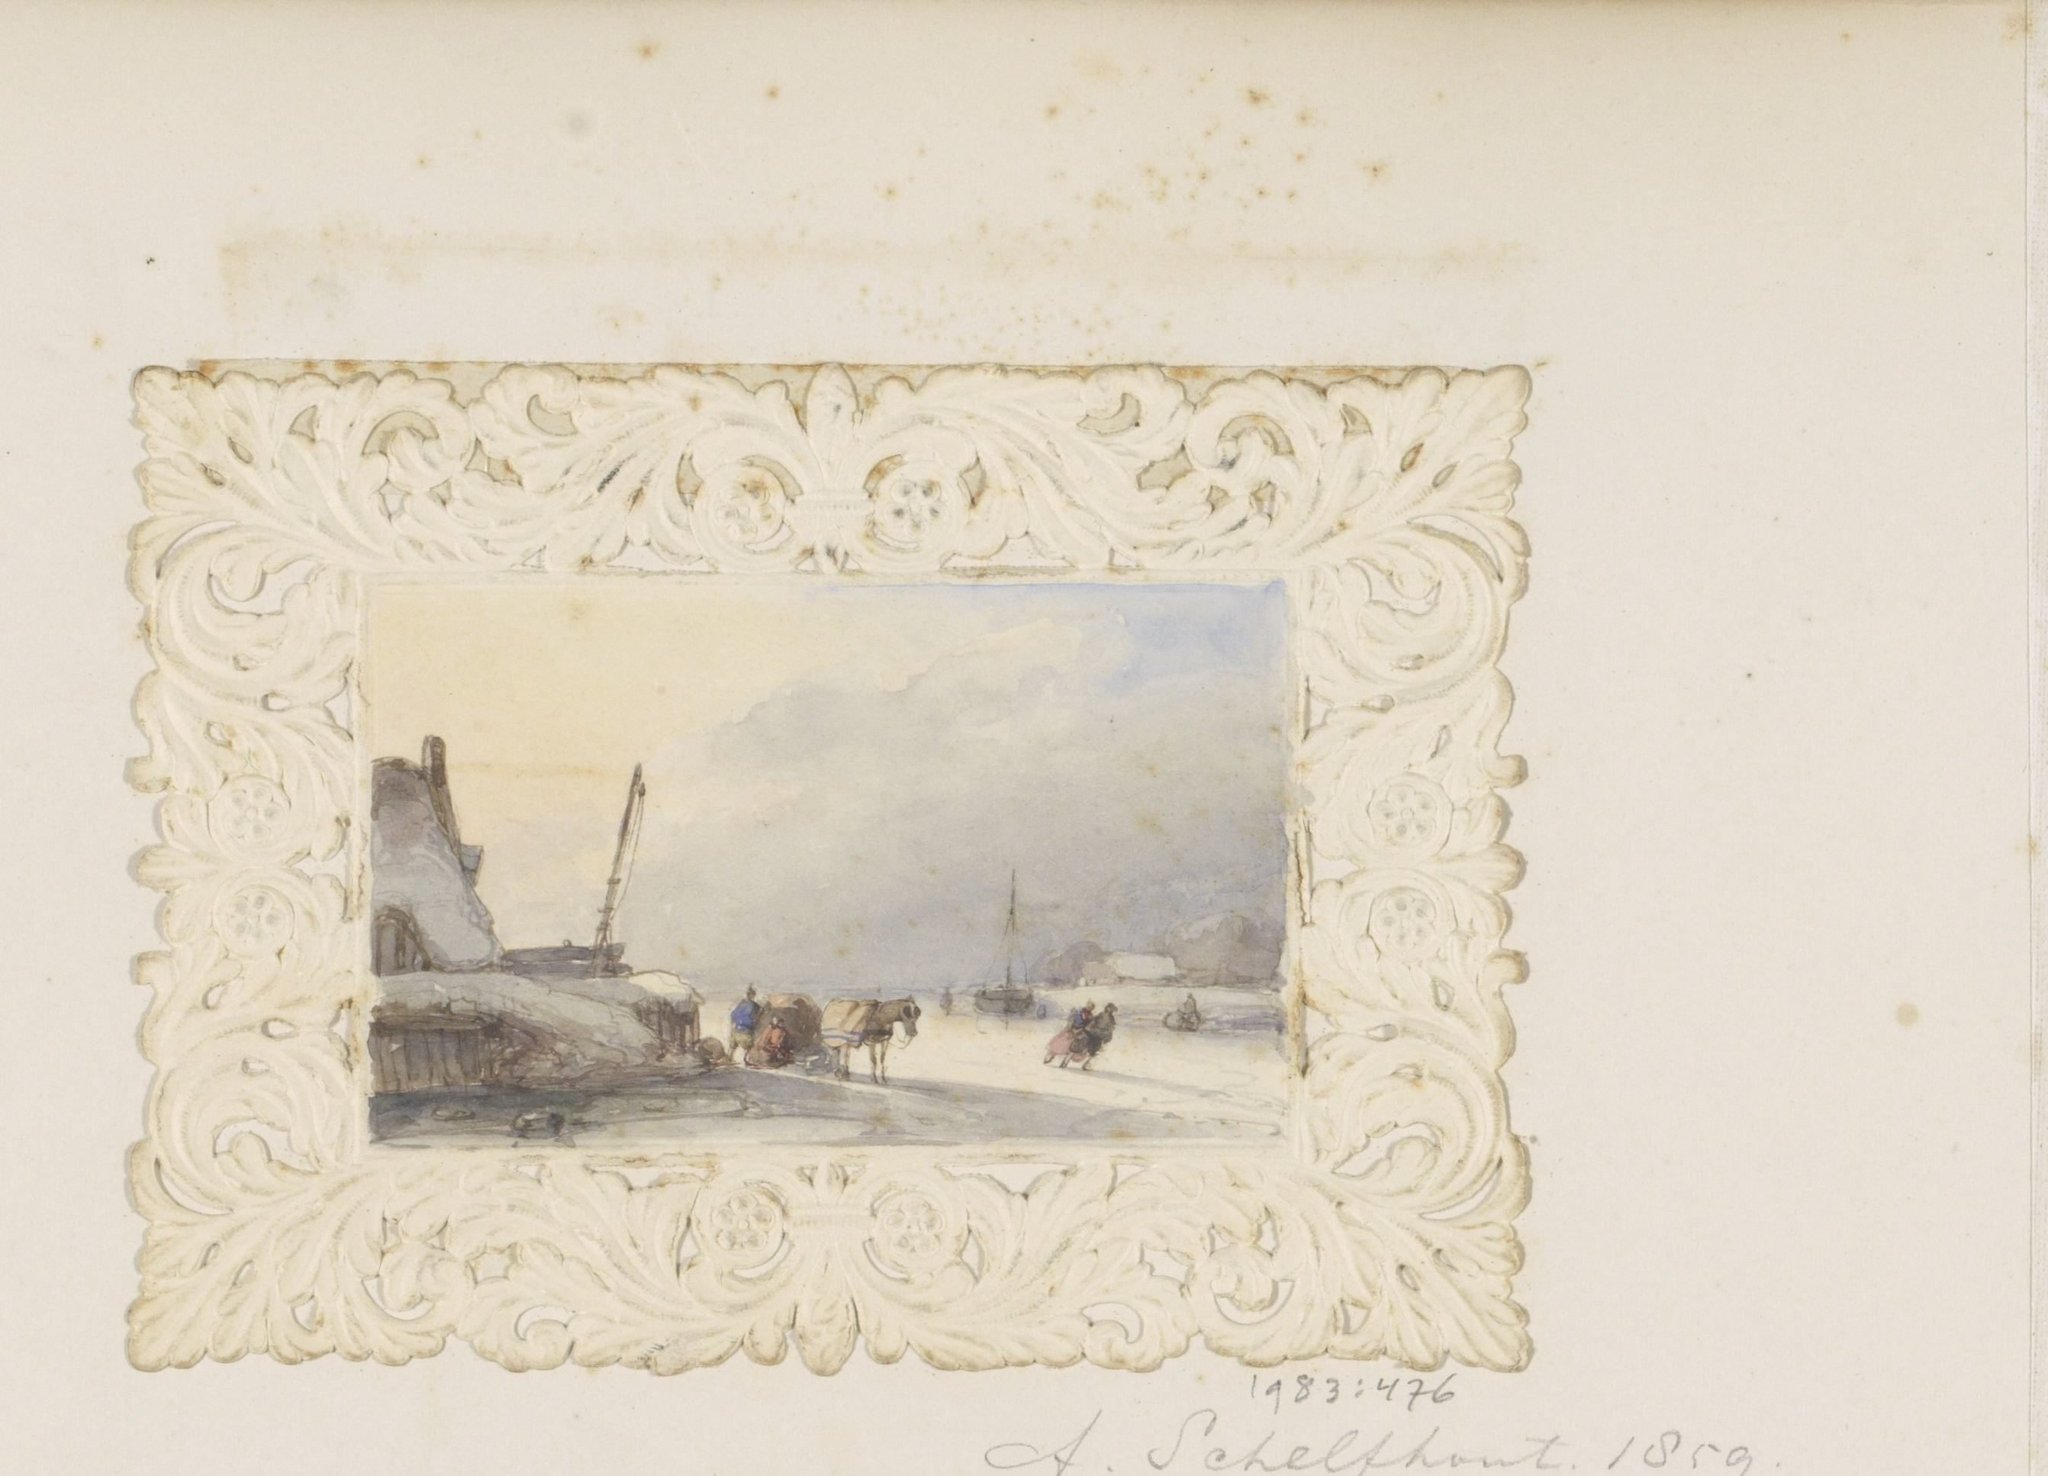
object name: album leaf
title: Winterlandschap met figuren en een bepakt paard op het ijs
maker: andreas schelfhout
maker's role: draughtsman, painter, print maker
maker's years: 1787-1870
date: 1859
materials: ink, paper, watercolor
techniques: brush, pen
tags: playing with snow and ice - cc - adult(s) ~ snow and ice, ice ~ freezing weather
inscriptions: signature and date: ‘A. Schelfhout f/ 1859’, number: ‘N 36[...]’